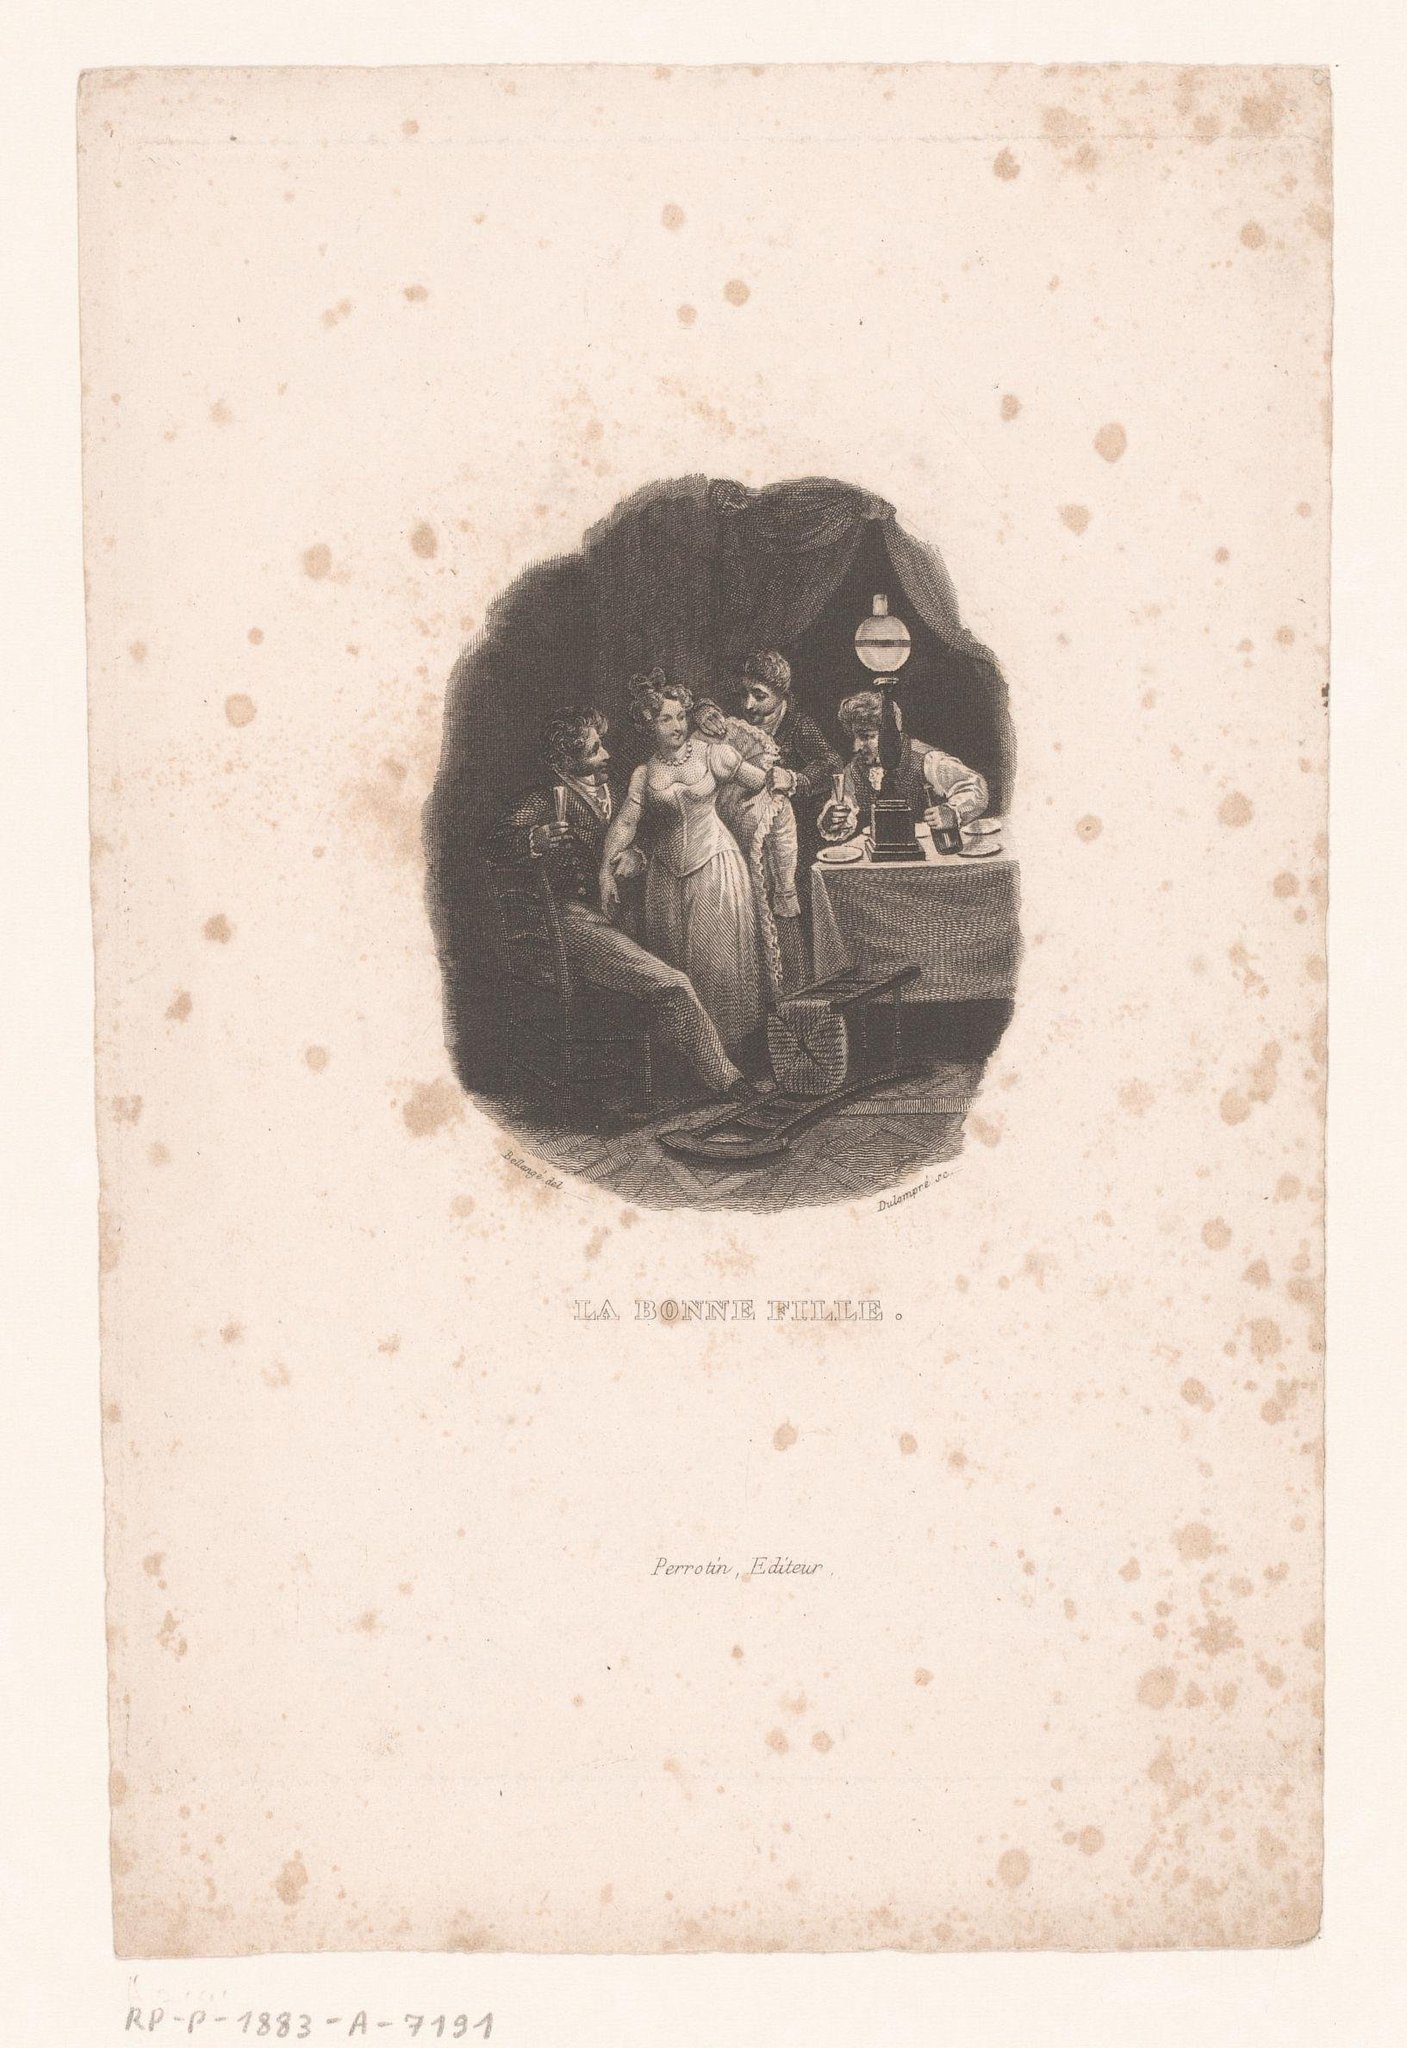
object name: print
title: La bonne fille.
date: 1799-1832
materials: paper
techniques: etching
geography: paris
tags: stripping, undressing someone else, relations between the sexes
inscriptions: collector's mark: Lugt 2227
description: Een man neemt de jas aan van een vrouw terwijl een tweede man wijn inschenkt en de derde haar dichterbij trekt. Haar stoel is op de grond gevallen.